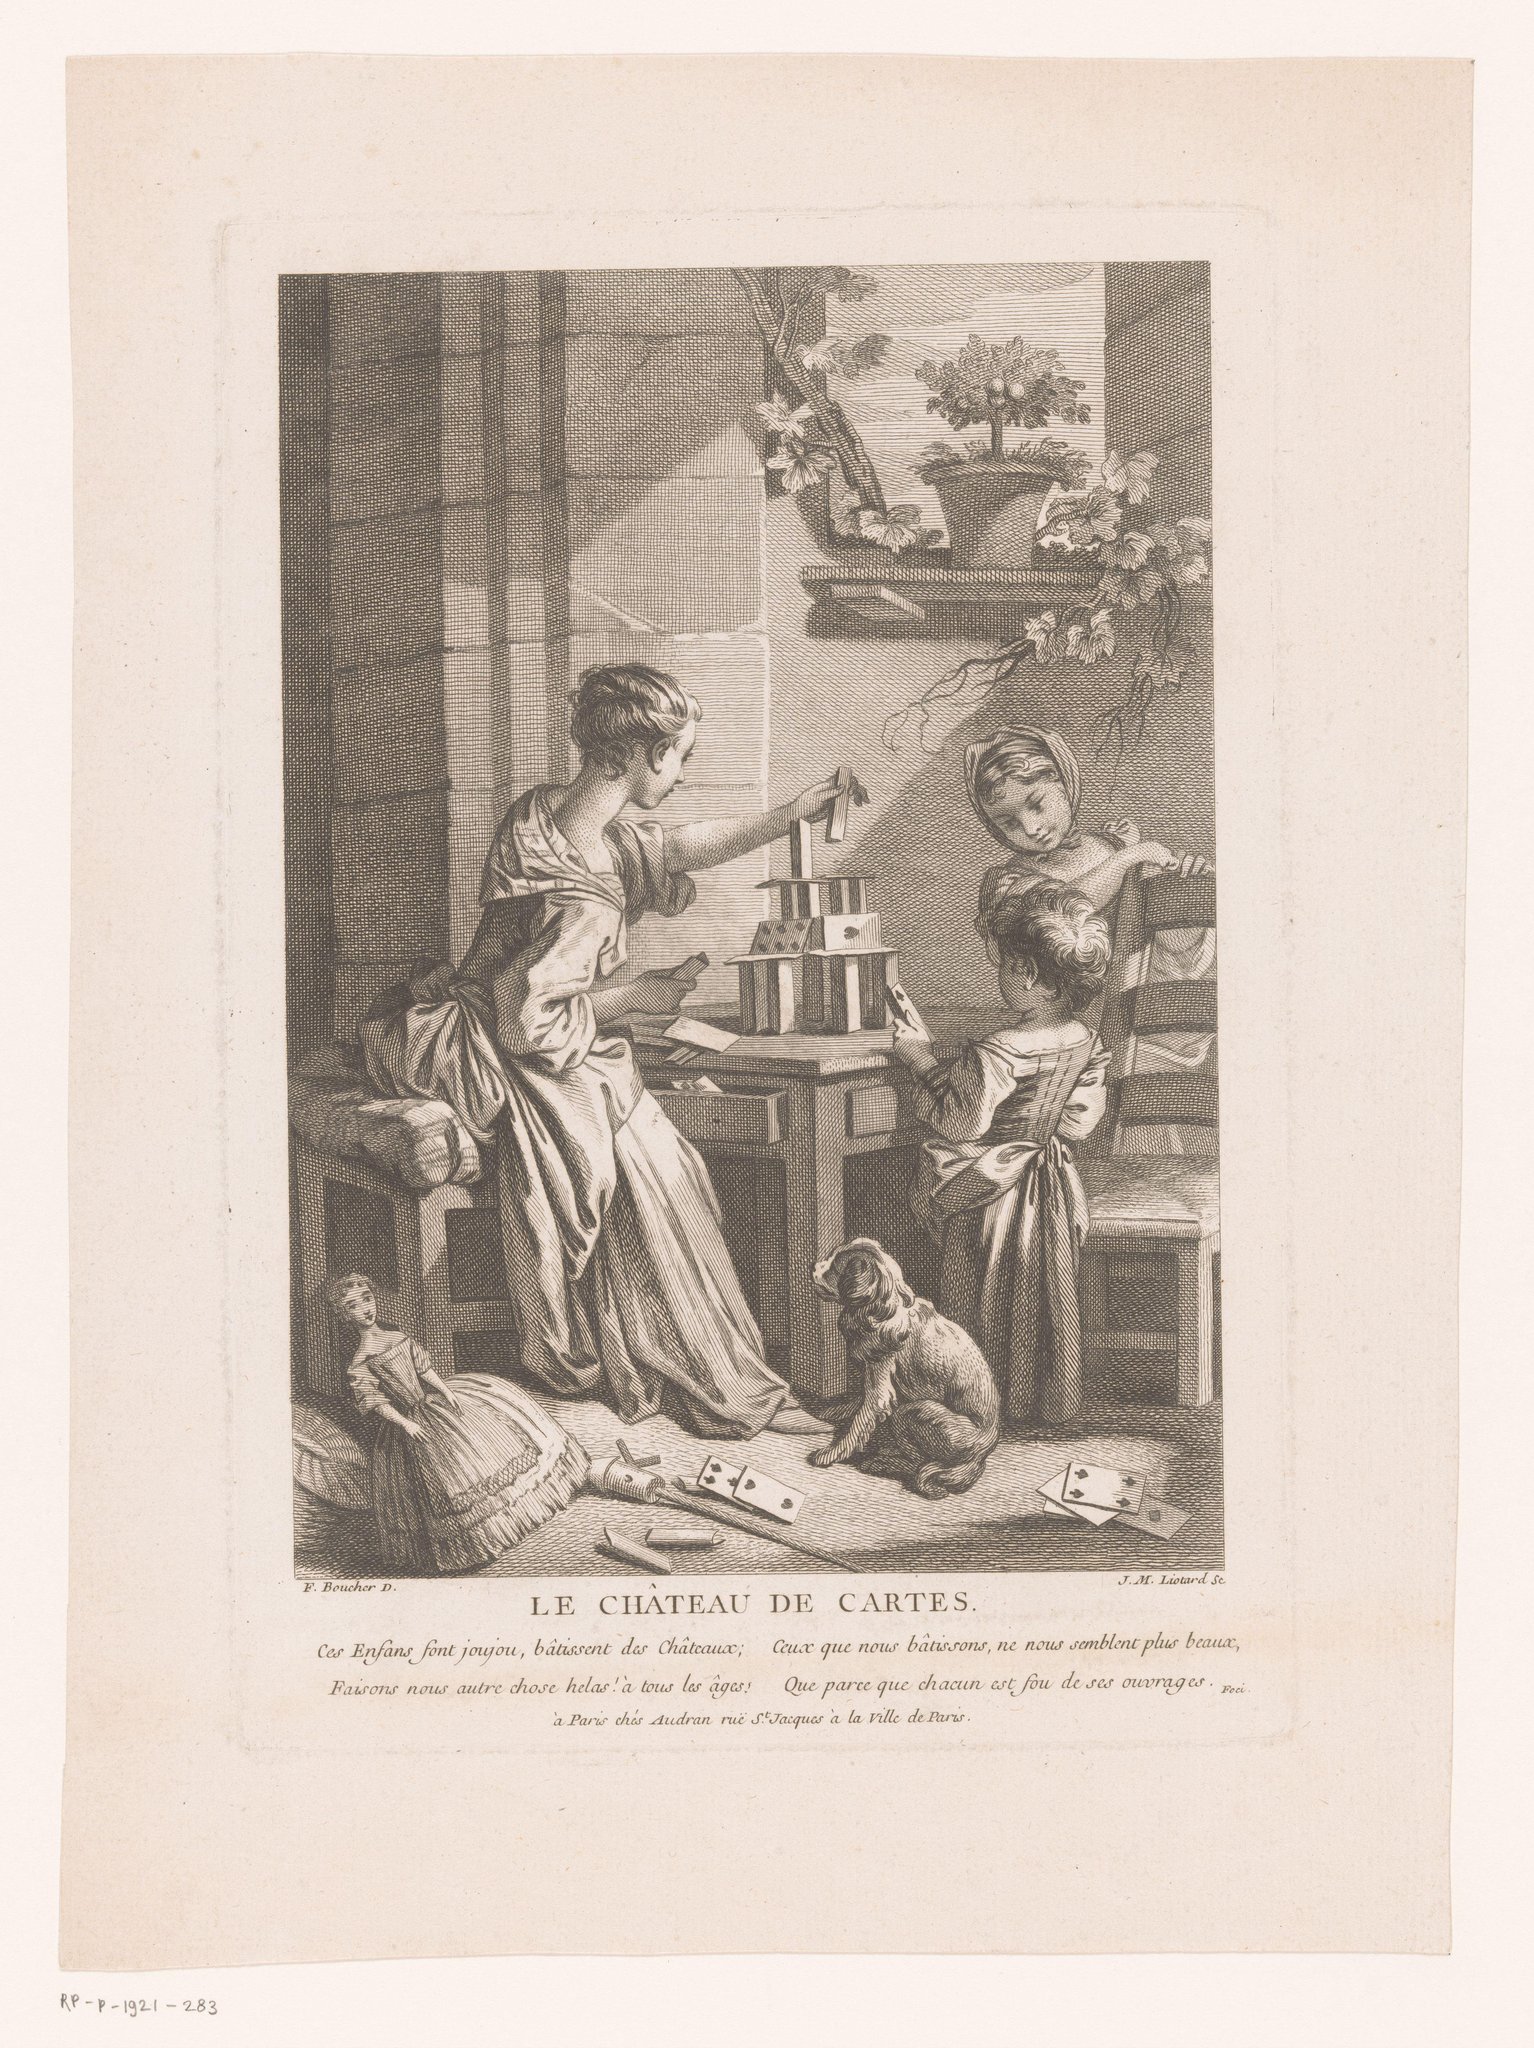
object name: print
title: Le Chateau de Cartes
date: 1712-1772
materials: paper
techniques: engraving, etching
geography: paris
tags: other children's games, (playing with) dolls, playing-cards, games using special objects (marbles, top, hoop, etc.)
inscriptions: collector's mark: Lugt 2233